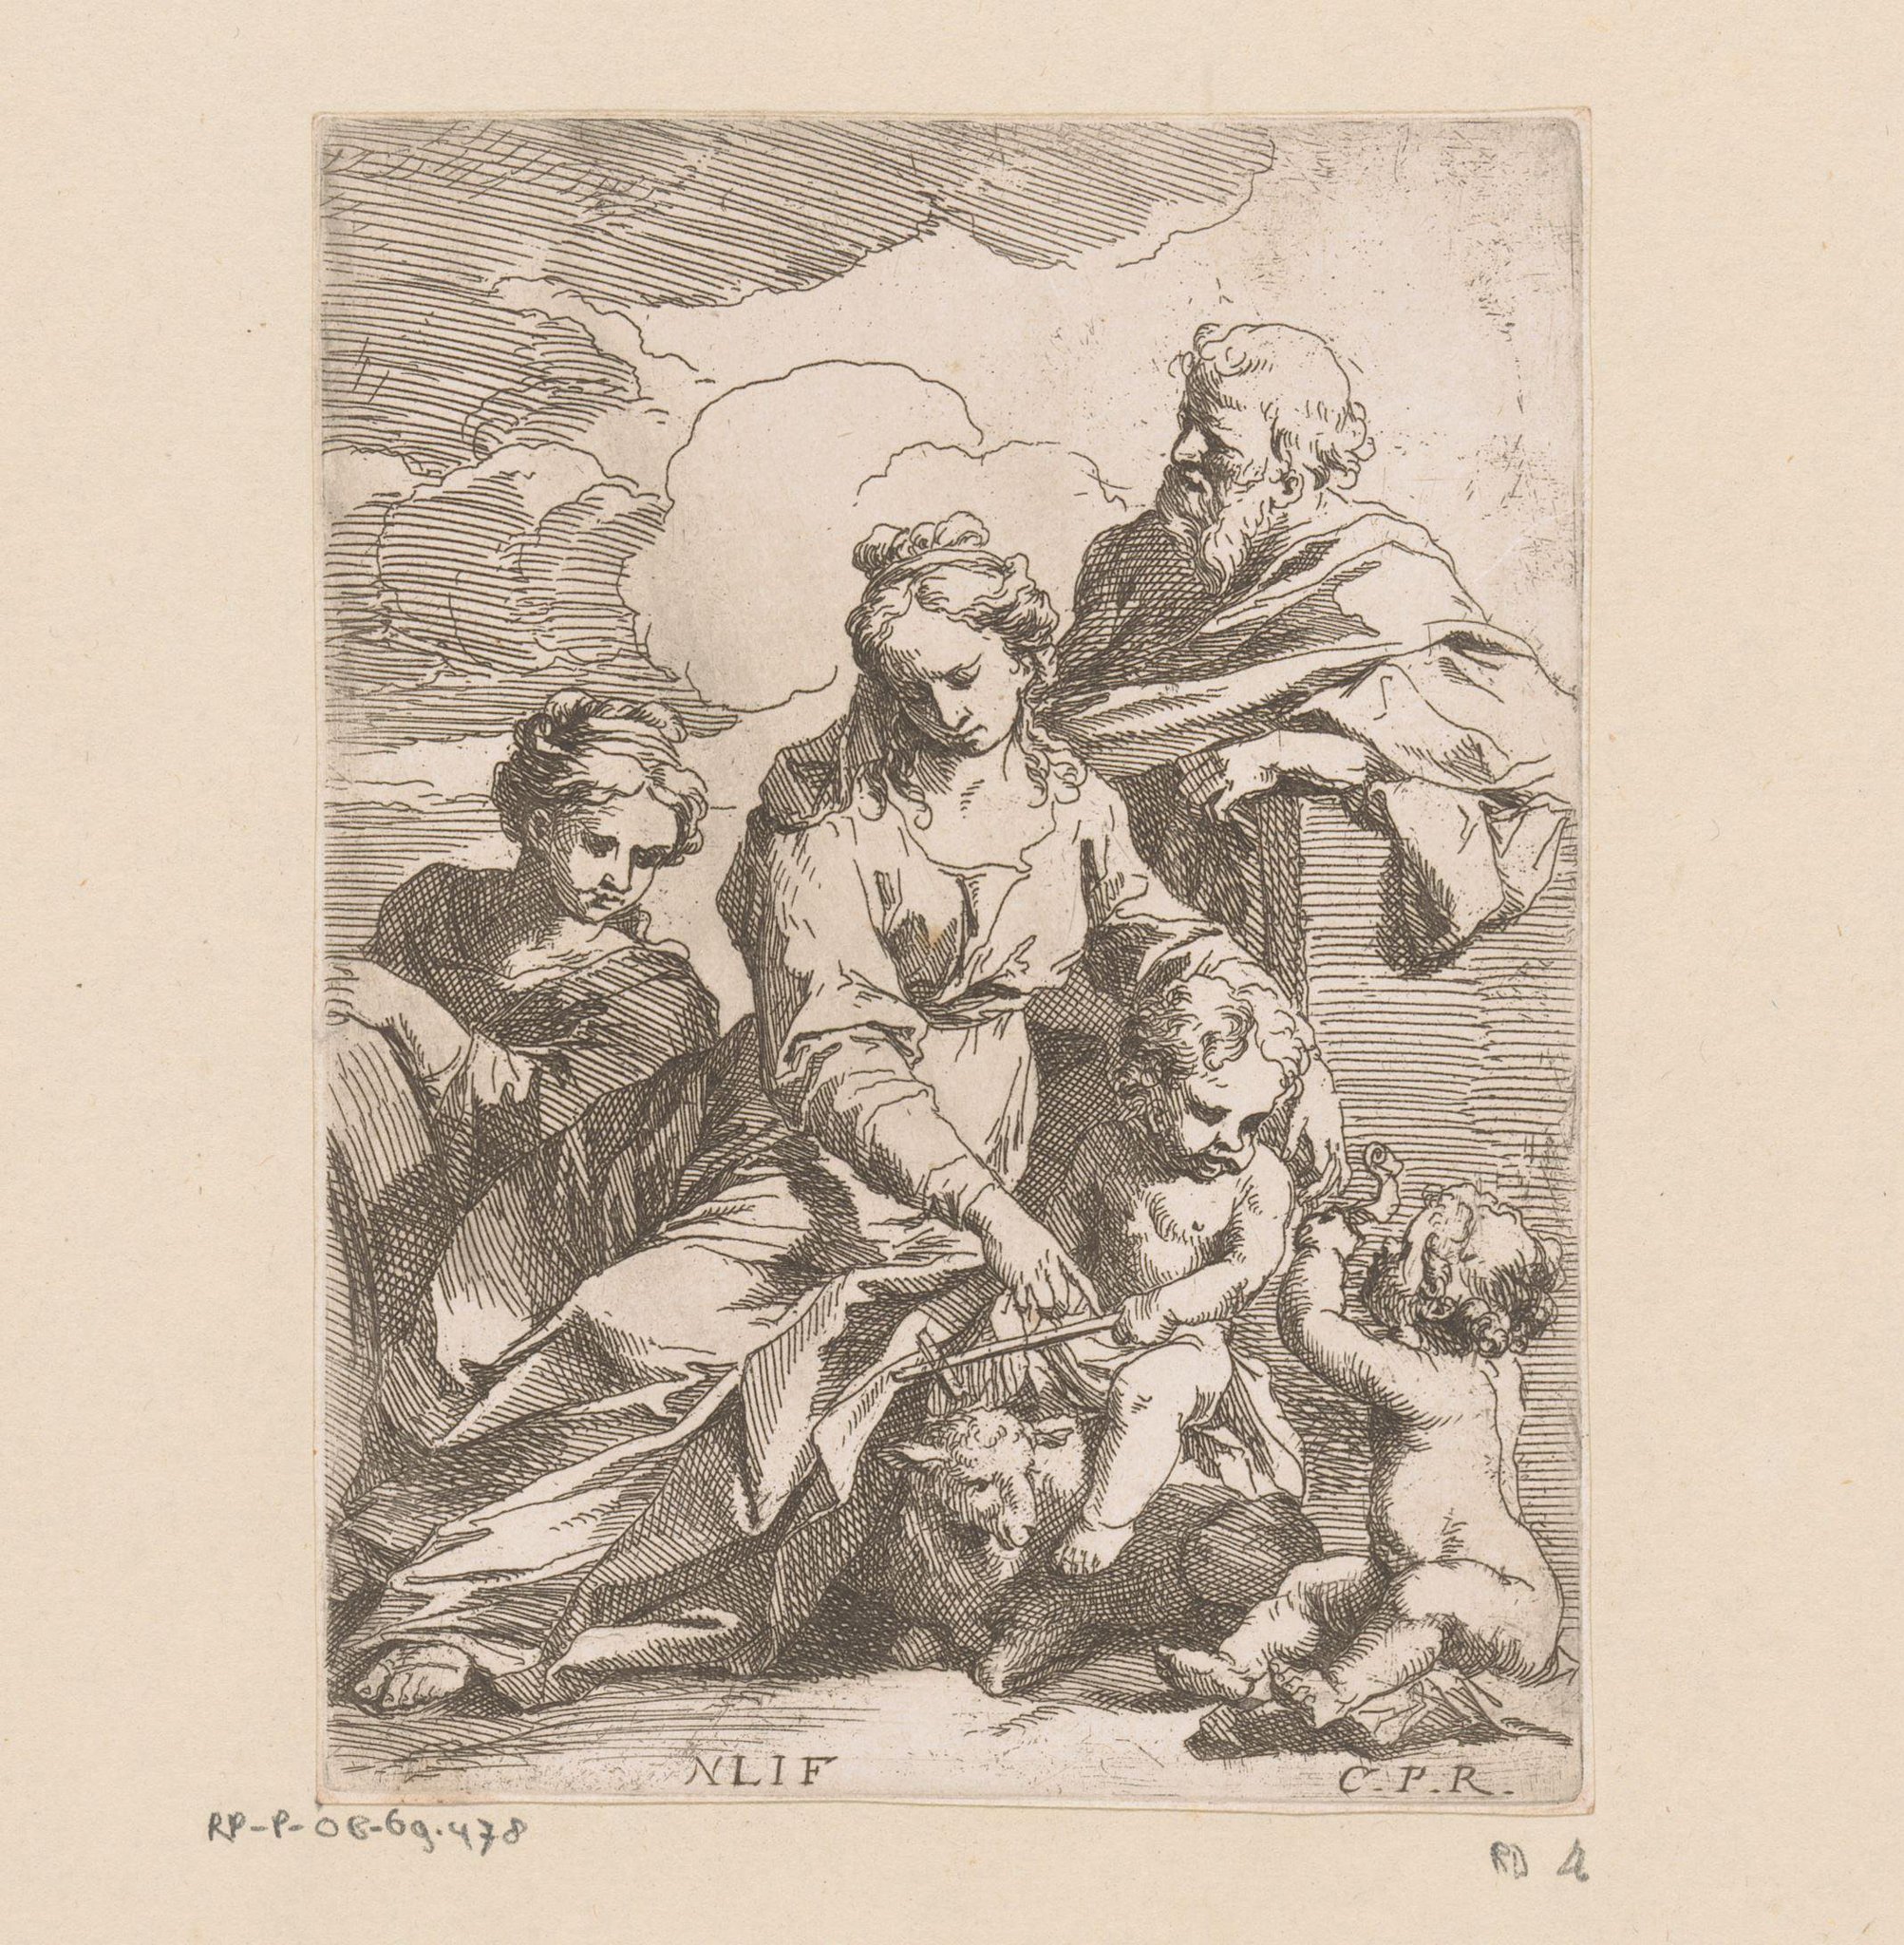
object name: print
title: Heilige familie met Johannes en de H. Catherina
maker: nicolas pierre loir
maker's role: painter, print maker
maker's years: 1624-1679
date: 1634-1679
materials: paper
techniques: etching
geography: france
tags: the virgin martyr catherine of alexandria; possible attributes: book, crown, emperor maxentius, palm-branch, ring, sword, wheel, holy family with john the baptist (as child)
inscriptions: collector's mark: Lugt 240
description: Maakt deel uit van een twaalfdelige serie met Heilige families en afbeeldingen van Maria met kind en Johannes de Doper.